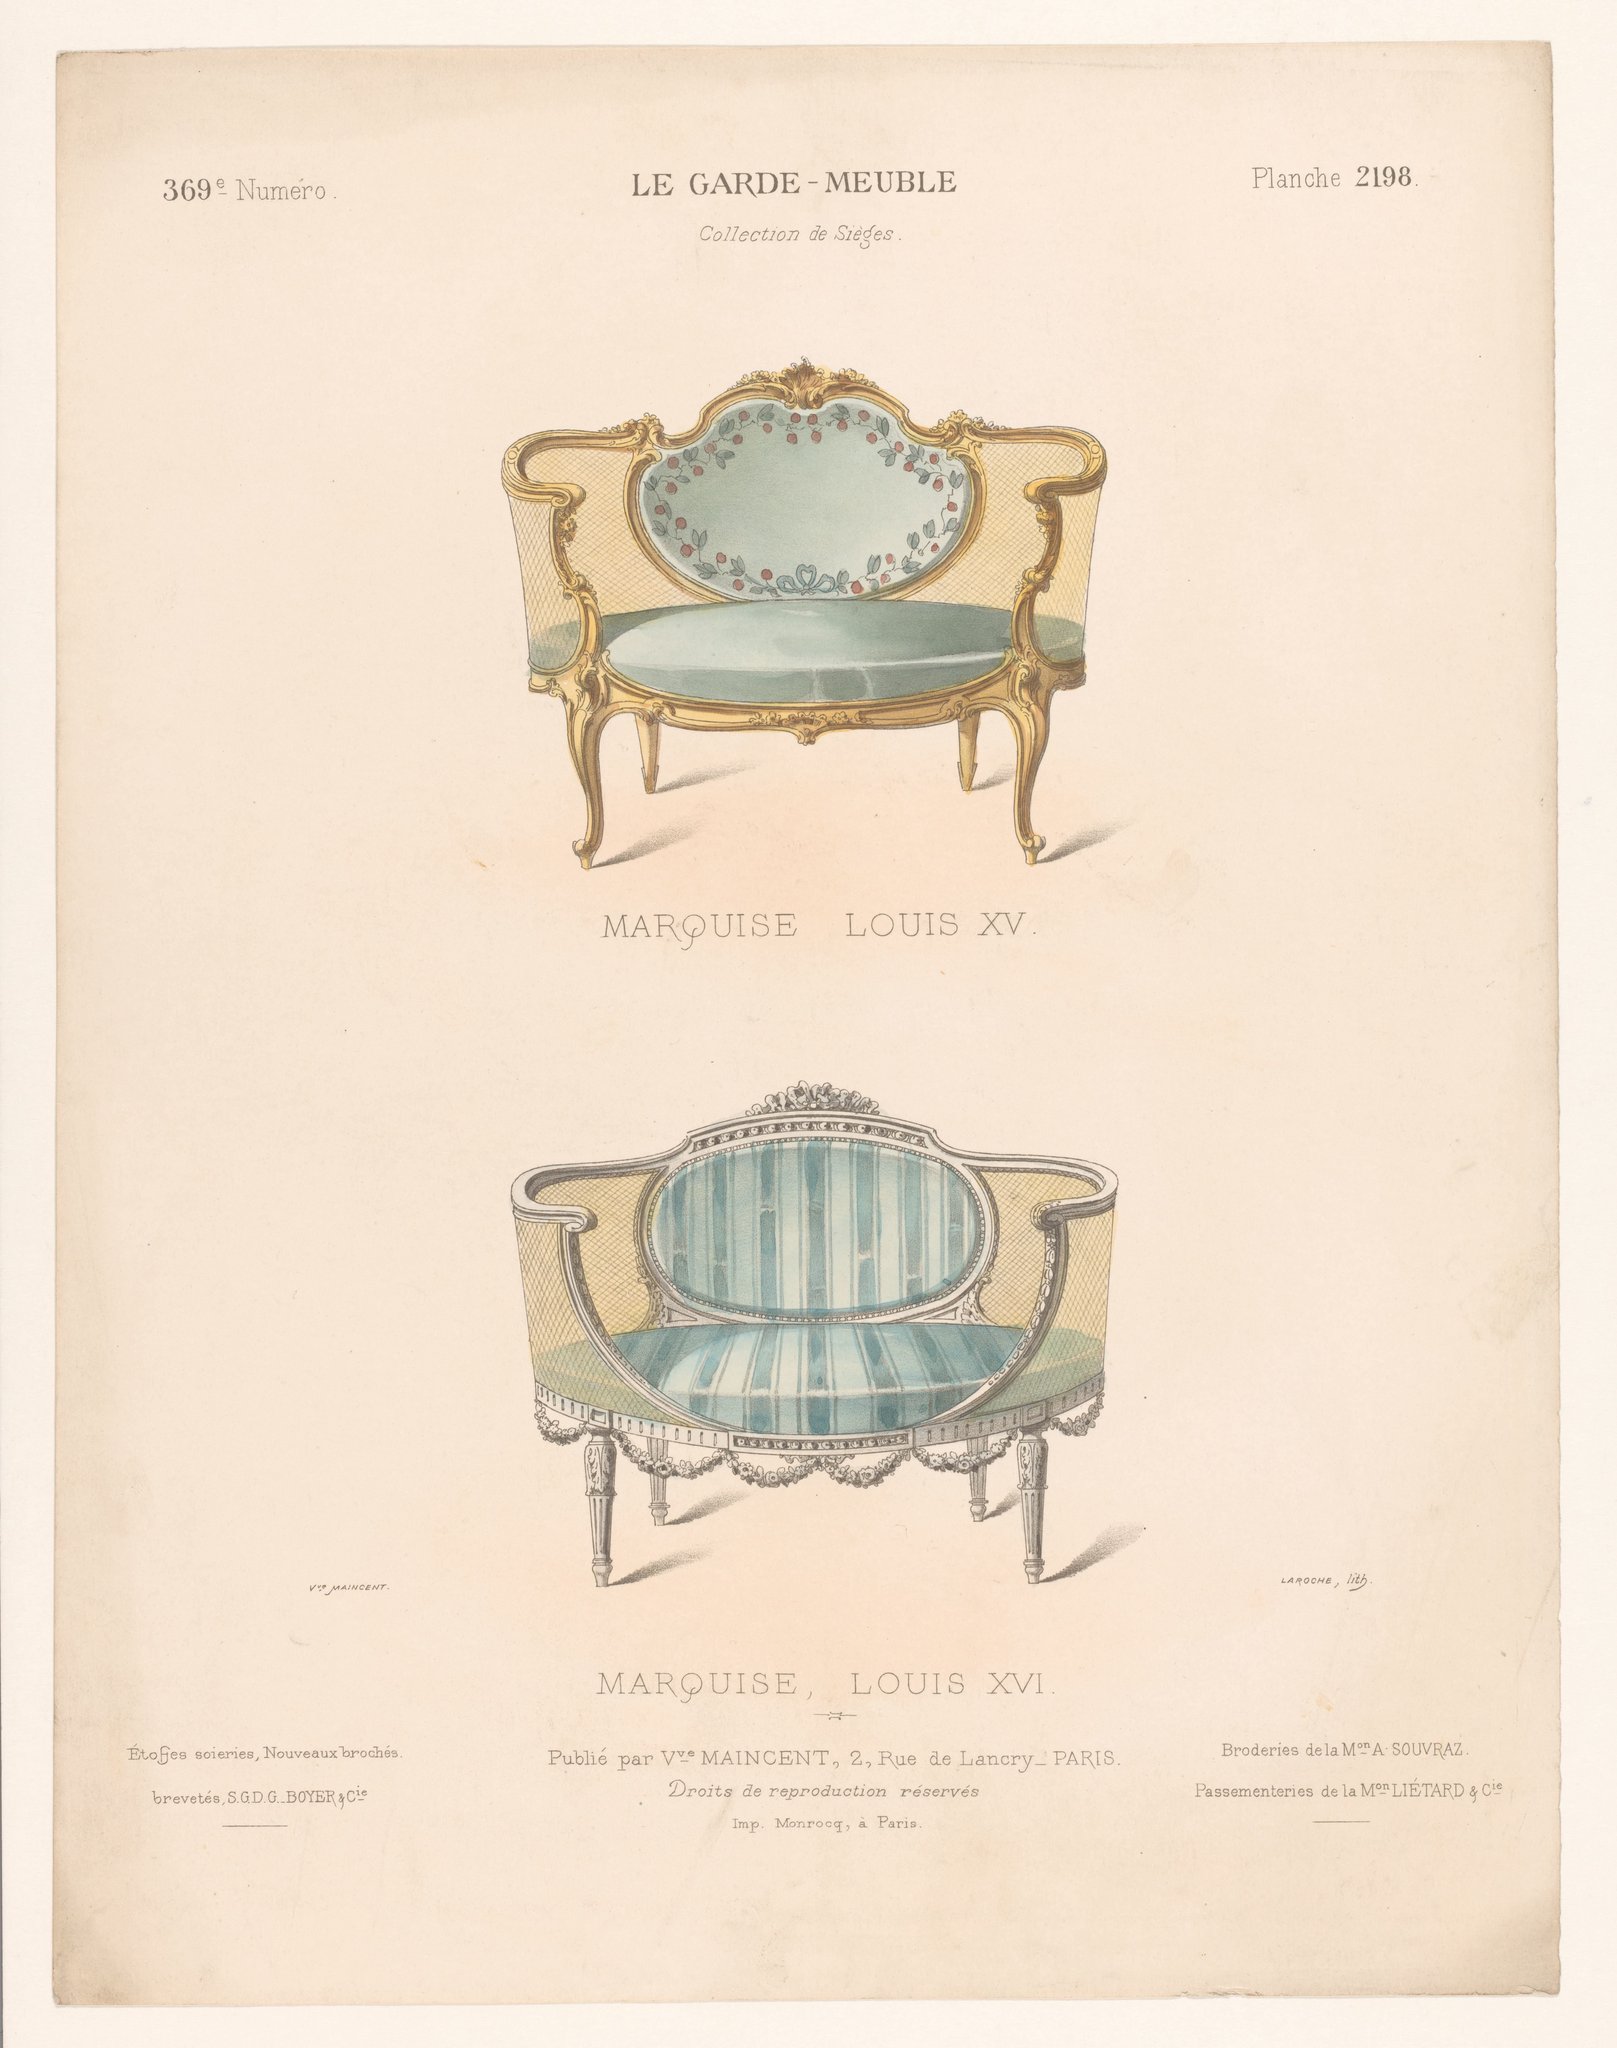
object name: print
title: Marquise Louis XV / Marquise, Louis XVI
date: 1895-1935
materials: paper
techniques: hand coloring, lithograph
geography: paris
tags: seating furniture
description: Ieder Livraison in de serie Le Garde-Meuble bevat negen platen: drie 'sièges' (zitmeubels), drie 'meubles' (diverse meubels zoals tafels en kasten) en drie 'tentures' (gordijnen en draperieën).